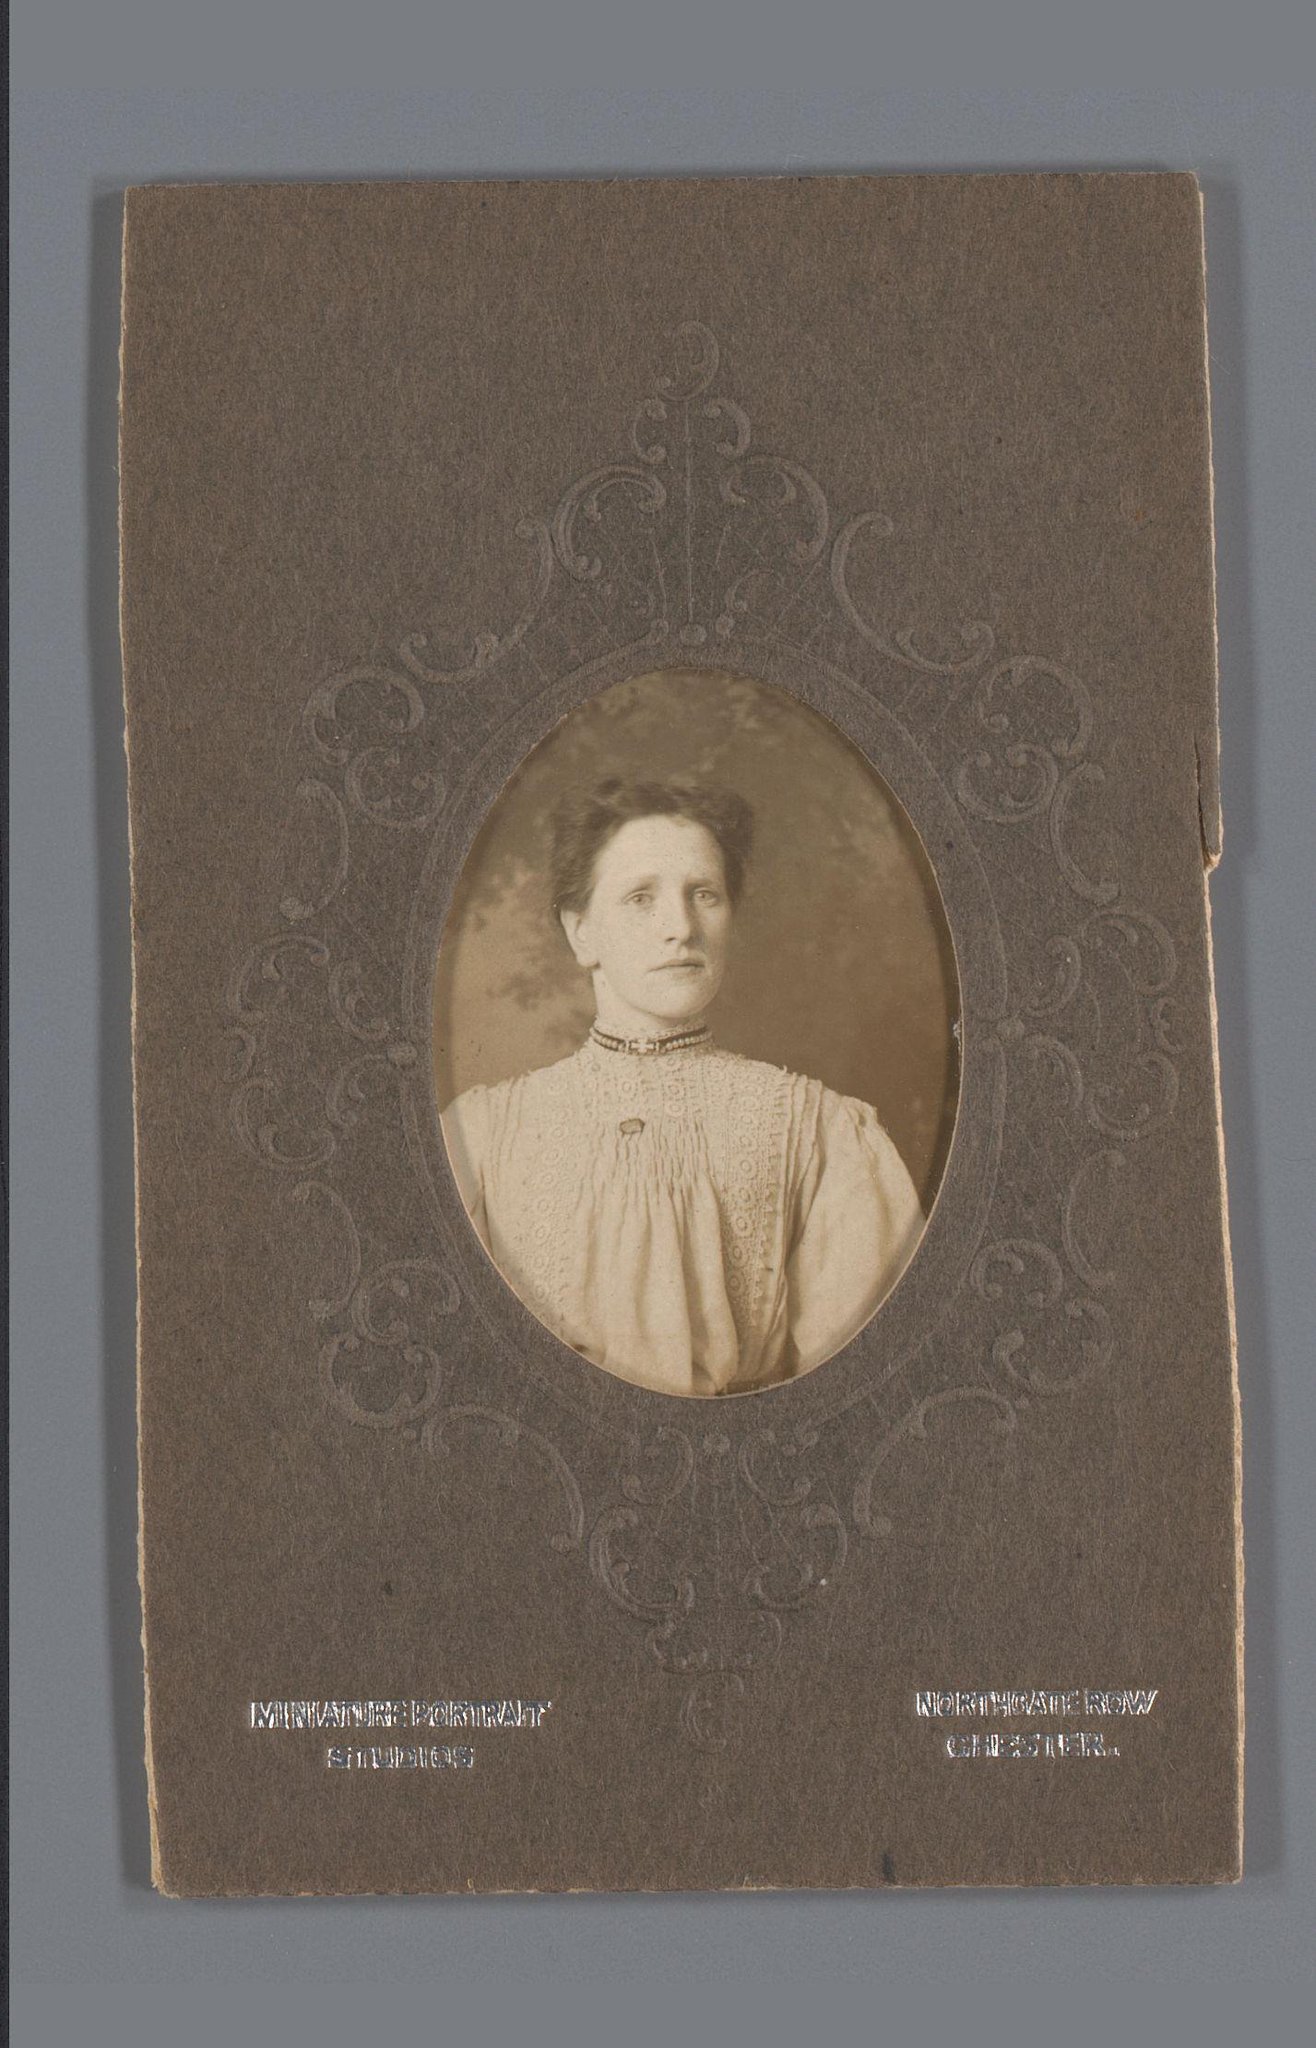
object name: photograph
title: Portret van een onbekende vrouw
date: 1905-1907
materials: paper, cardboard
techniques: gelatin silver print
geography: chester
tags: adult woman, anonymous historical person portrayed